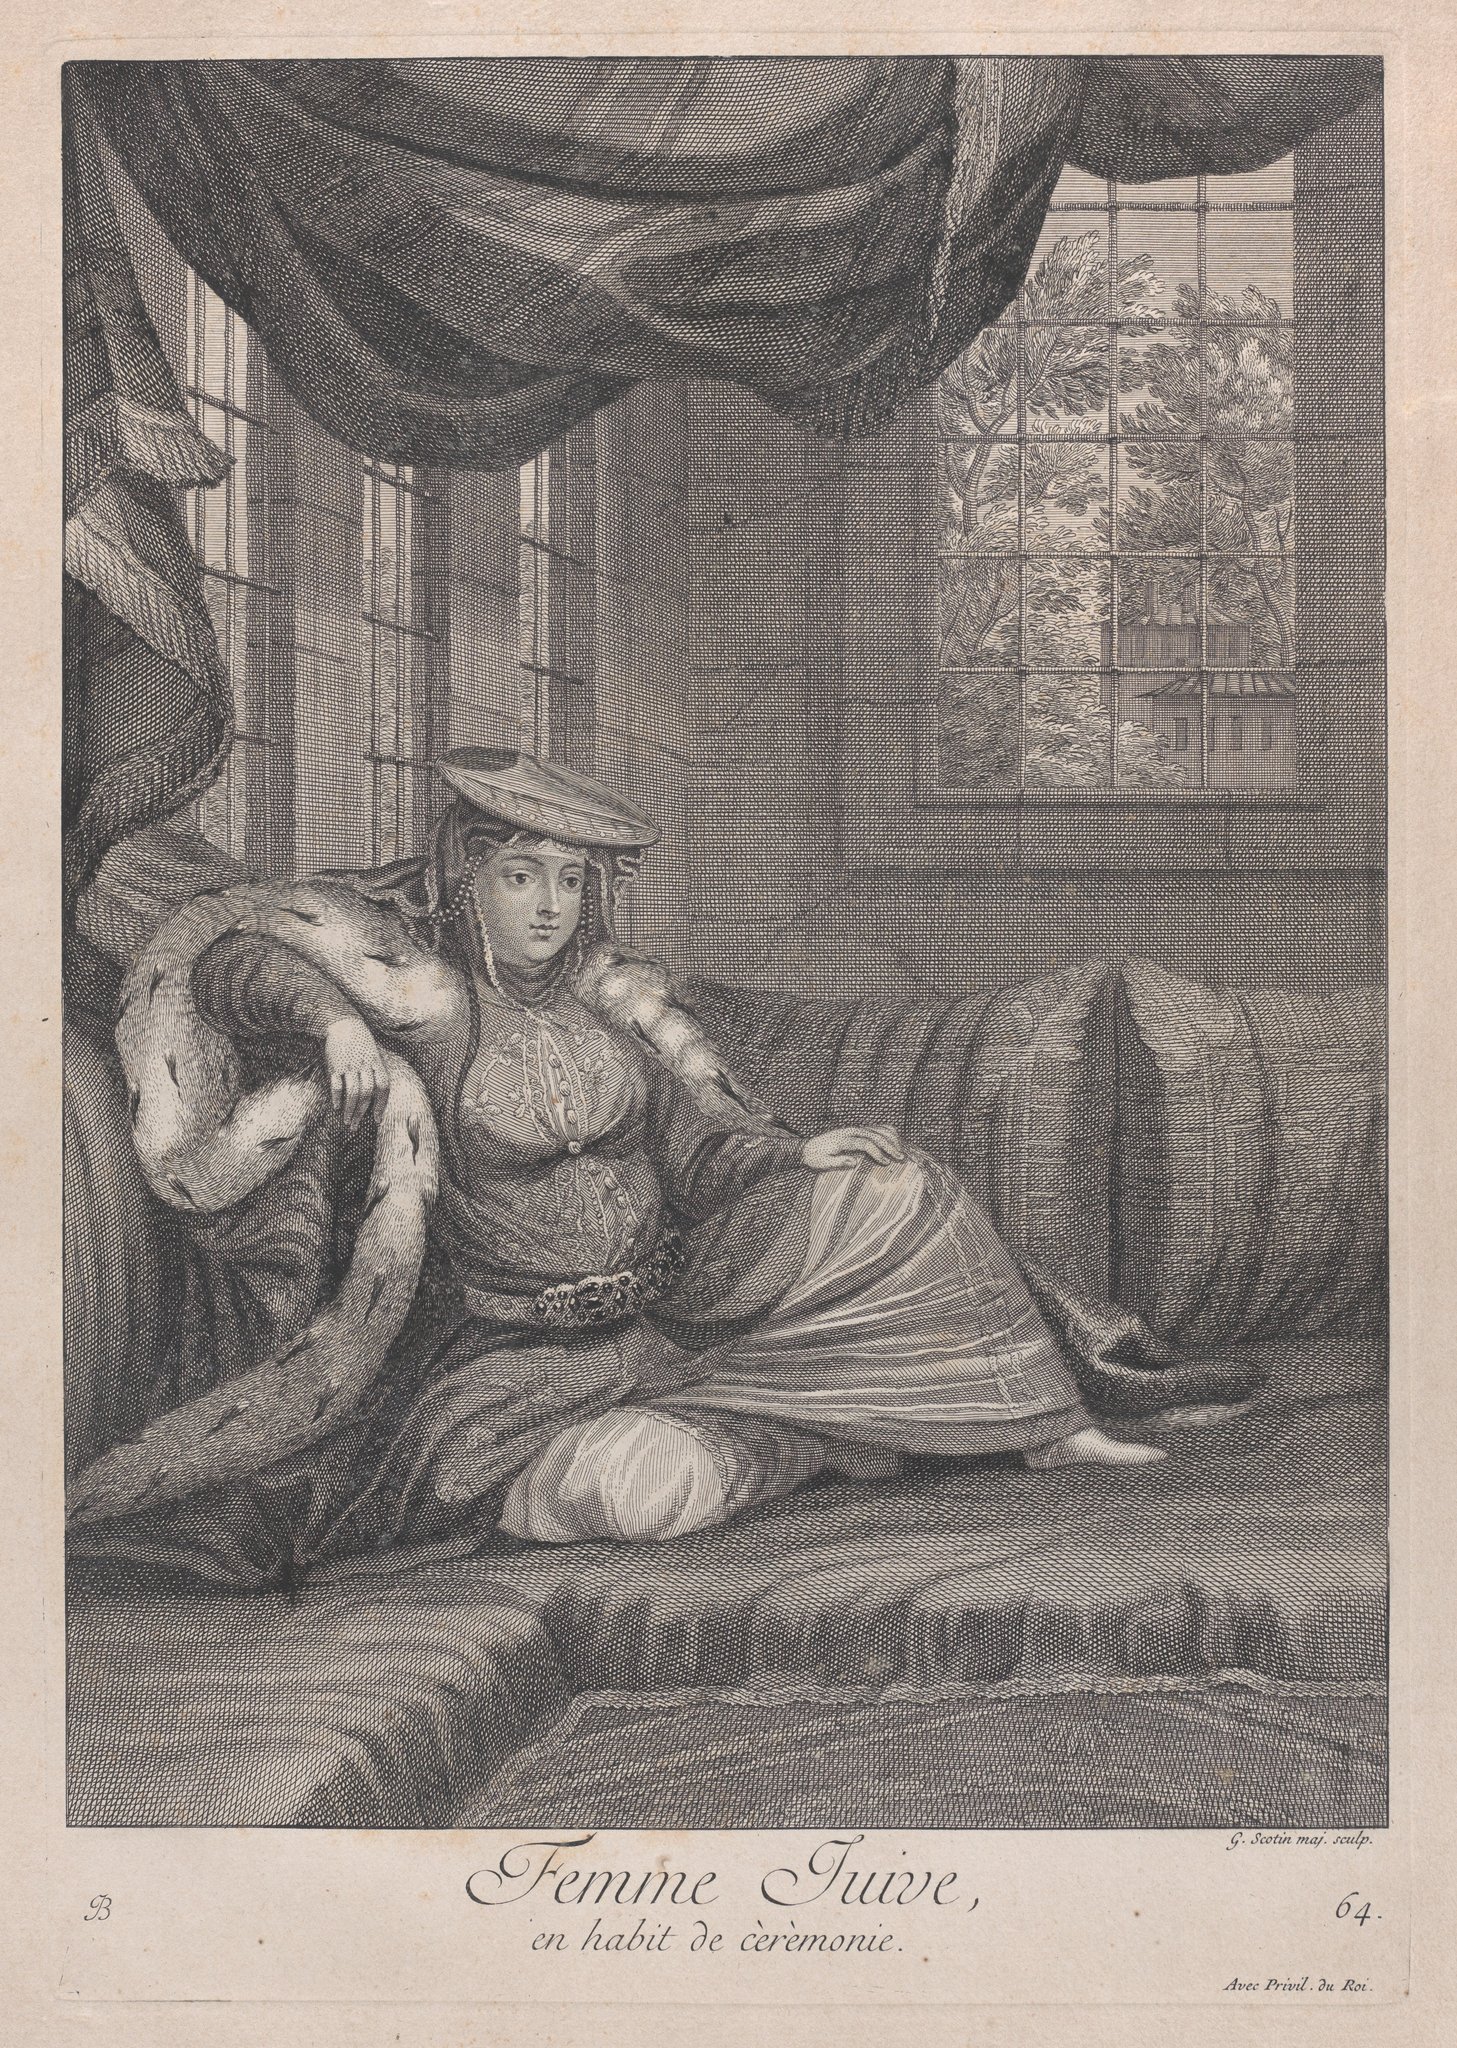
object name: print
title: Femme Juive, en habit de cèrèmonie, plate 64 from "Recueil de cent estampes représentent differentes nations du Levant"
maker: jean baptiste vanmour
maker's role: artist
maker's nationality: french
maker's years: 1671-1737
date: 1714-1715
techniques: engraving, etching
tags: women